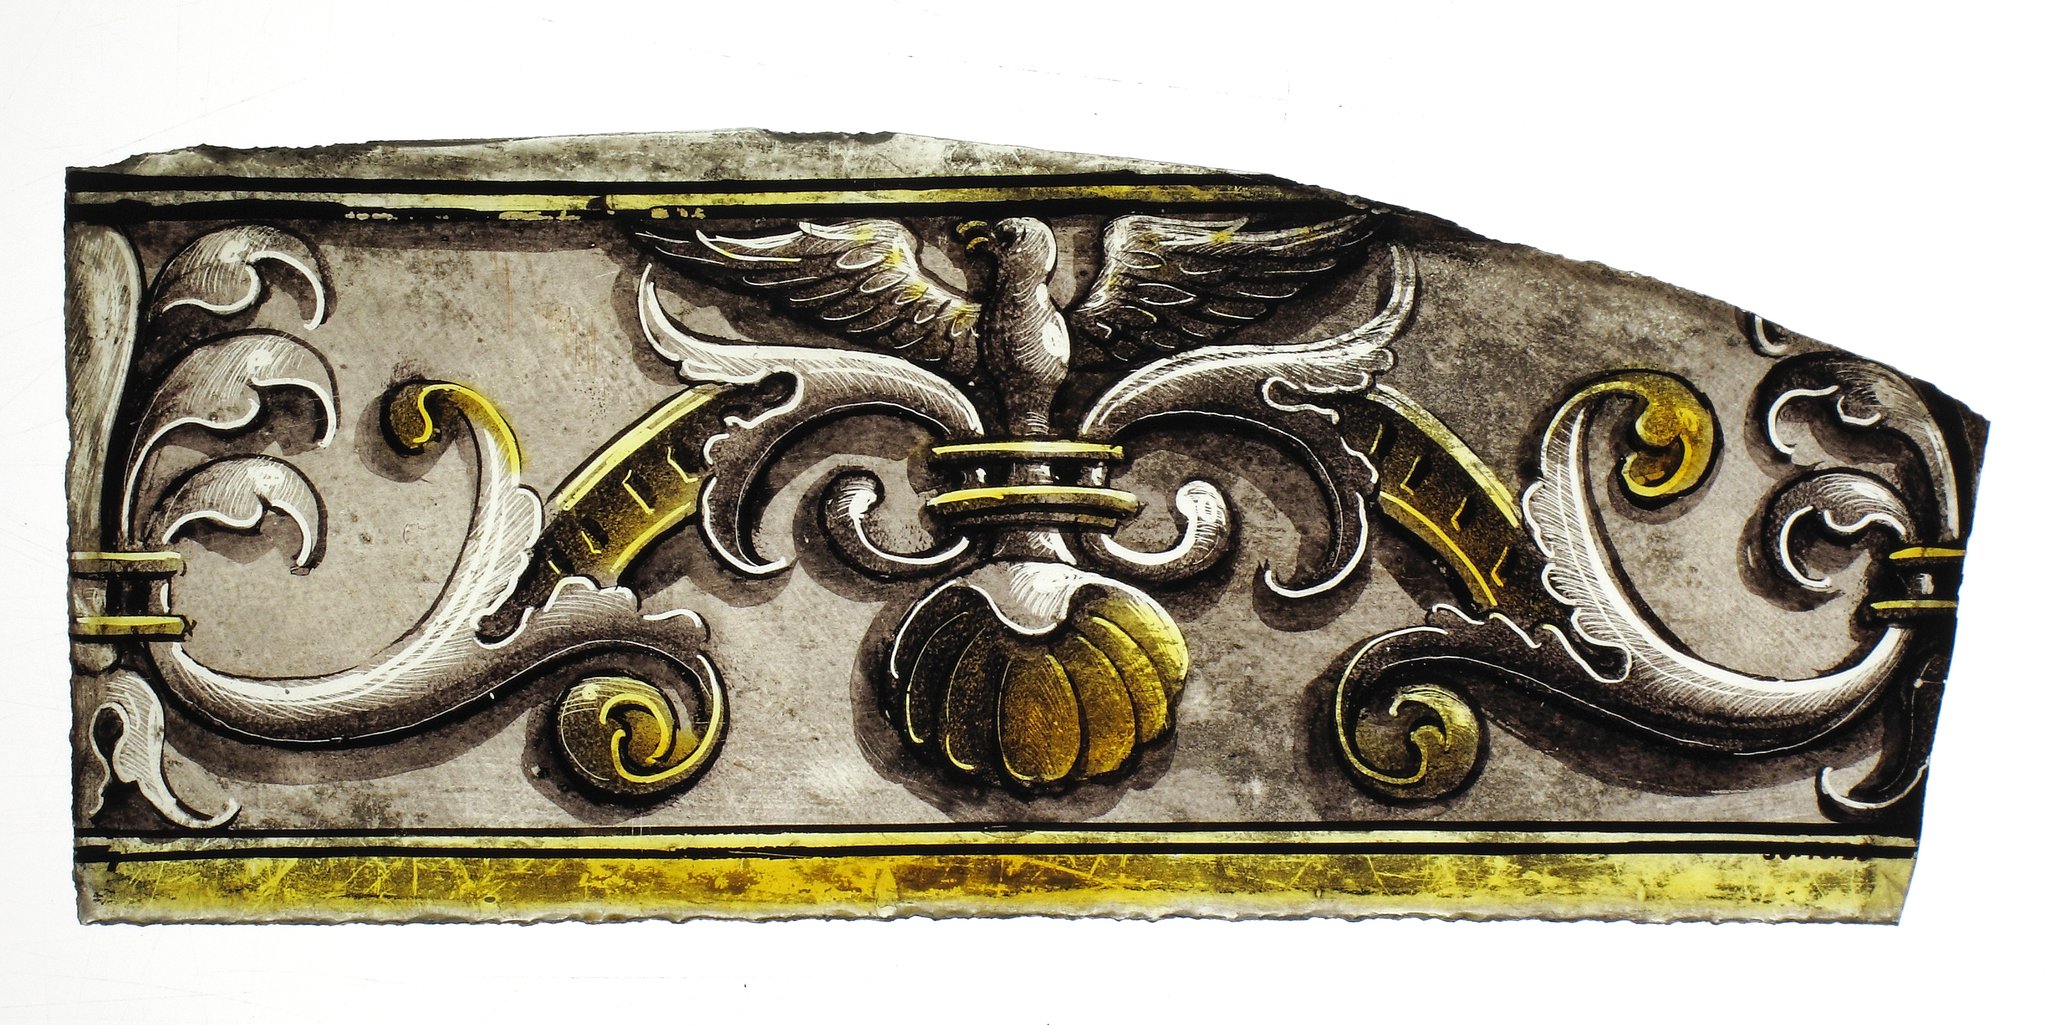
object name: fragment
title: Glass Fragment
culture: european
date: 1501-1600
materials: glass